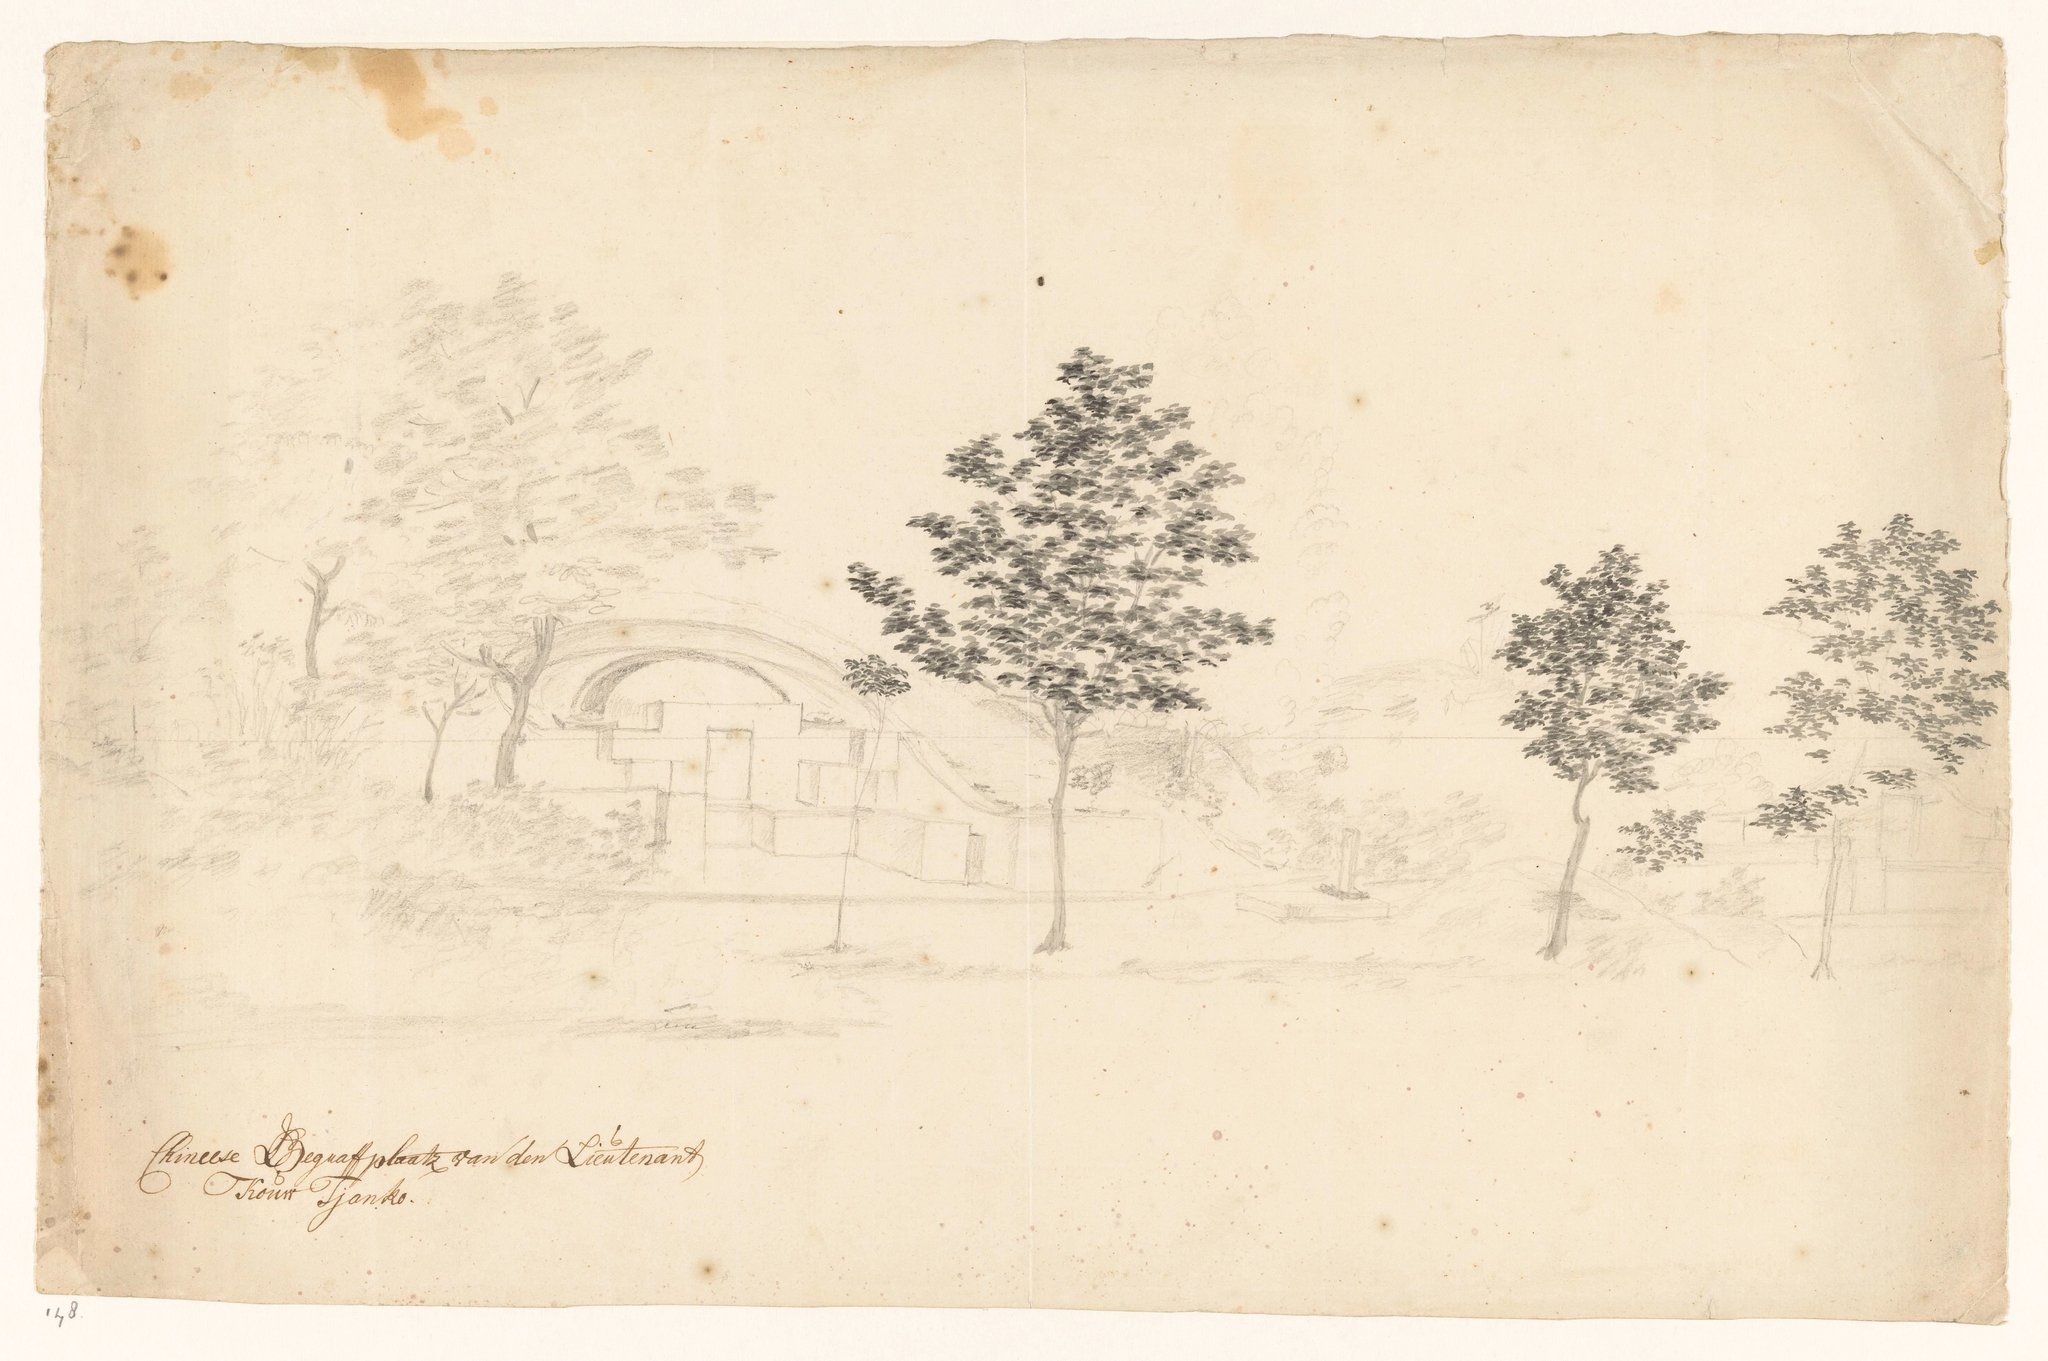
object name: drawing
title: Chineese Begraffplaatz van den Lieutenant Kouw Tjanko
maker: jan brandes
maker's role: draughtsman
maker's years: 1743-1808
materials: paper, pencil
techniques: brush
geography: batavia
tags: churchyard, cemetery, batavia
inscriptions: inscription: ‘Chineese Begraffplaatz van den Lieutenant Kouw Tjanko’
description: De Chinese begraafplaats bij Brandes' huis buiten Batavia. De VOC bestuurt de Chinezen in Batavia door middel van Chinese voormannen waarvan de voornaamste de 'kapitein Chinees' is, daarna diens luitenants.